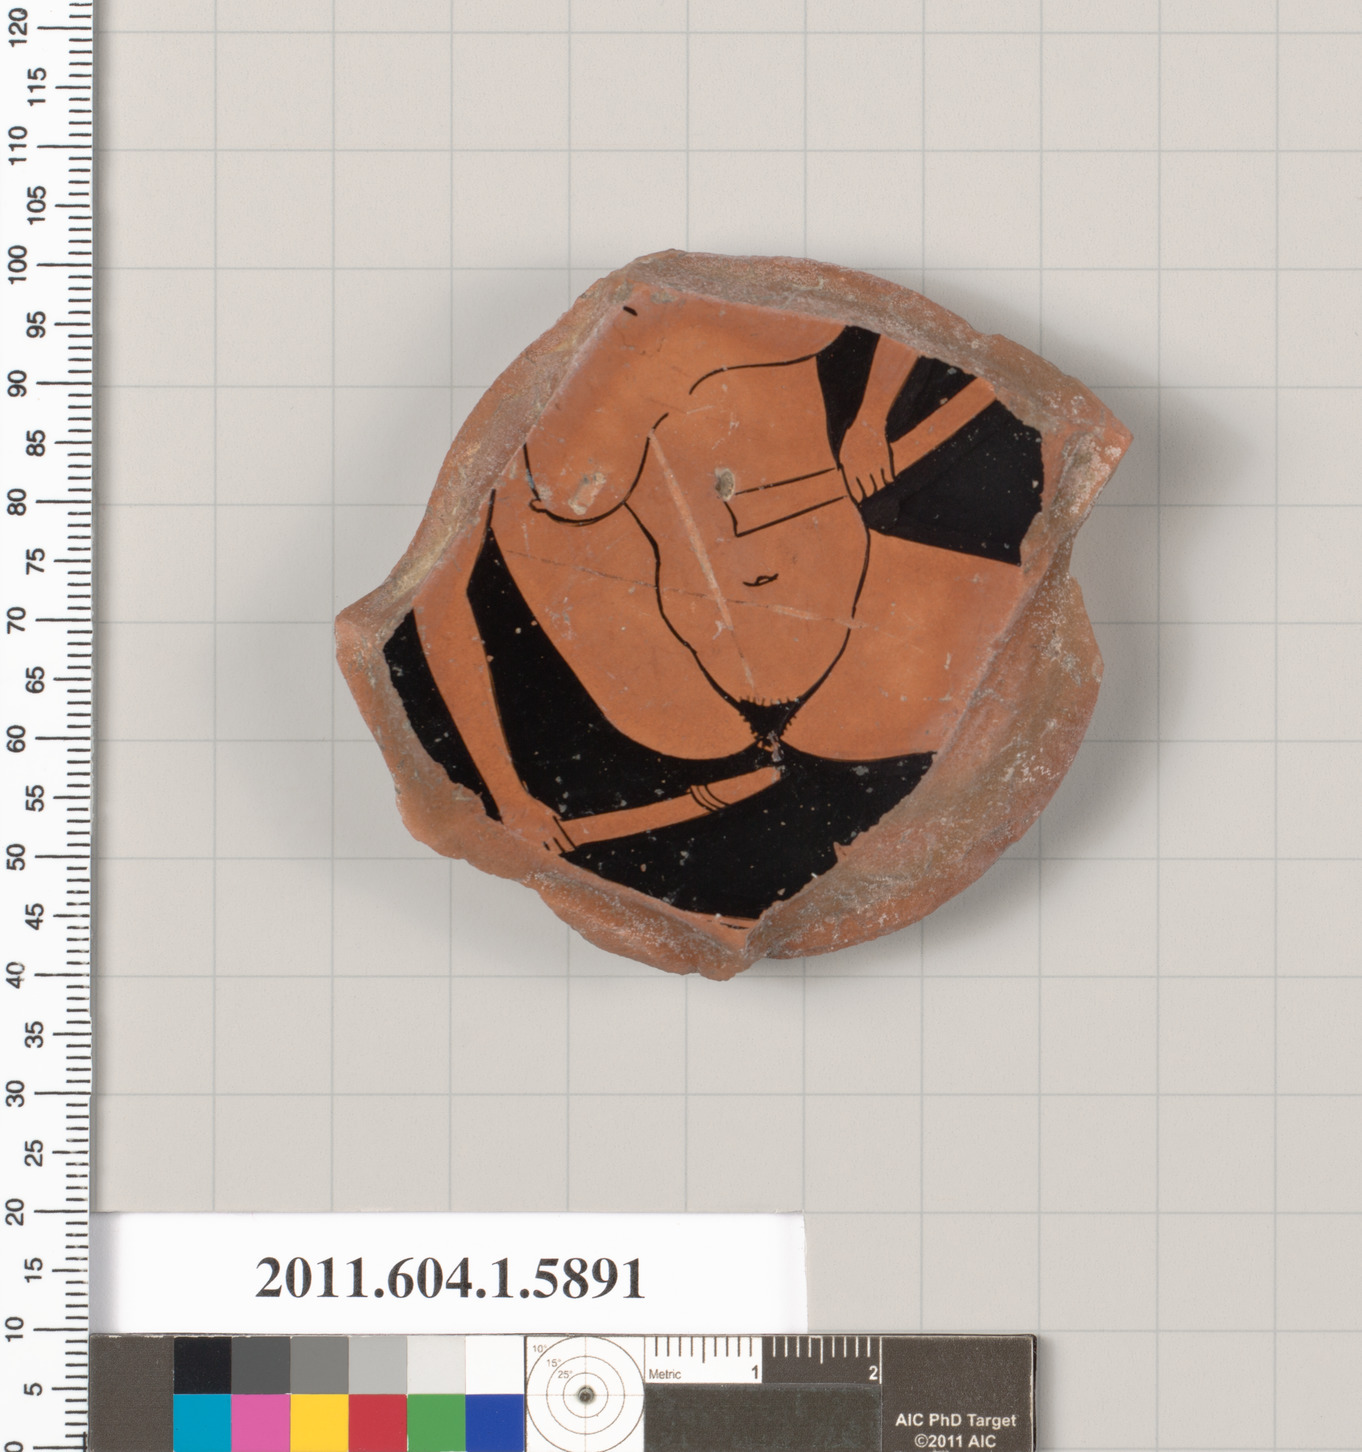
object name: kylix fragment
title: Terracotta fragment of a kylix (drinking cup)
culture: greek, attic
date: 520-500 BCE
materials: terracotta